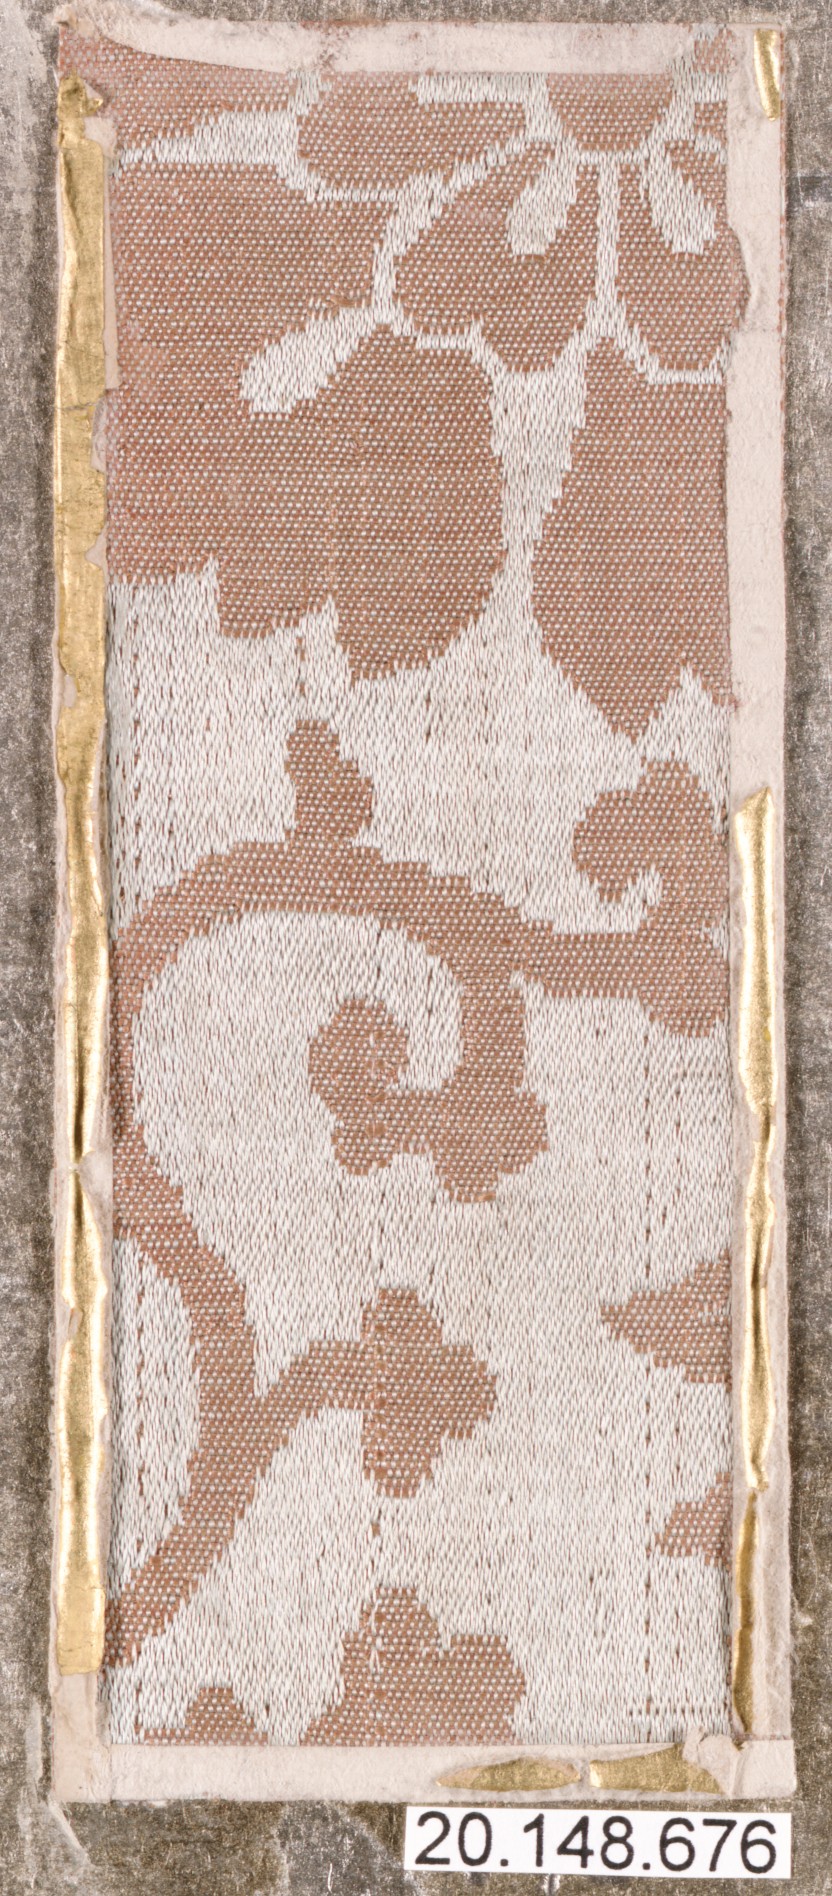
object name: piece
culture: japanese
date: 1701-1800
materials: silk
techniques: compound weave